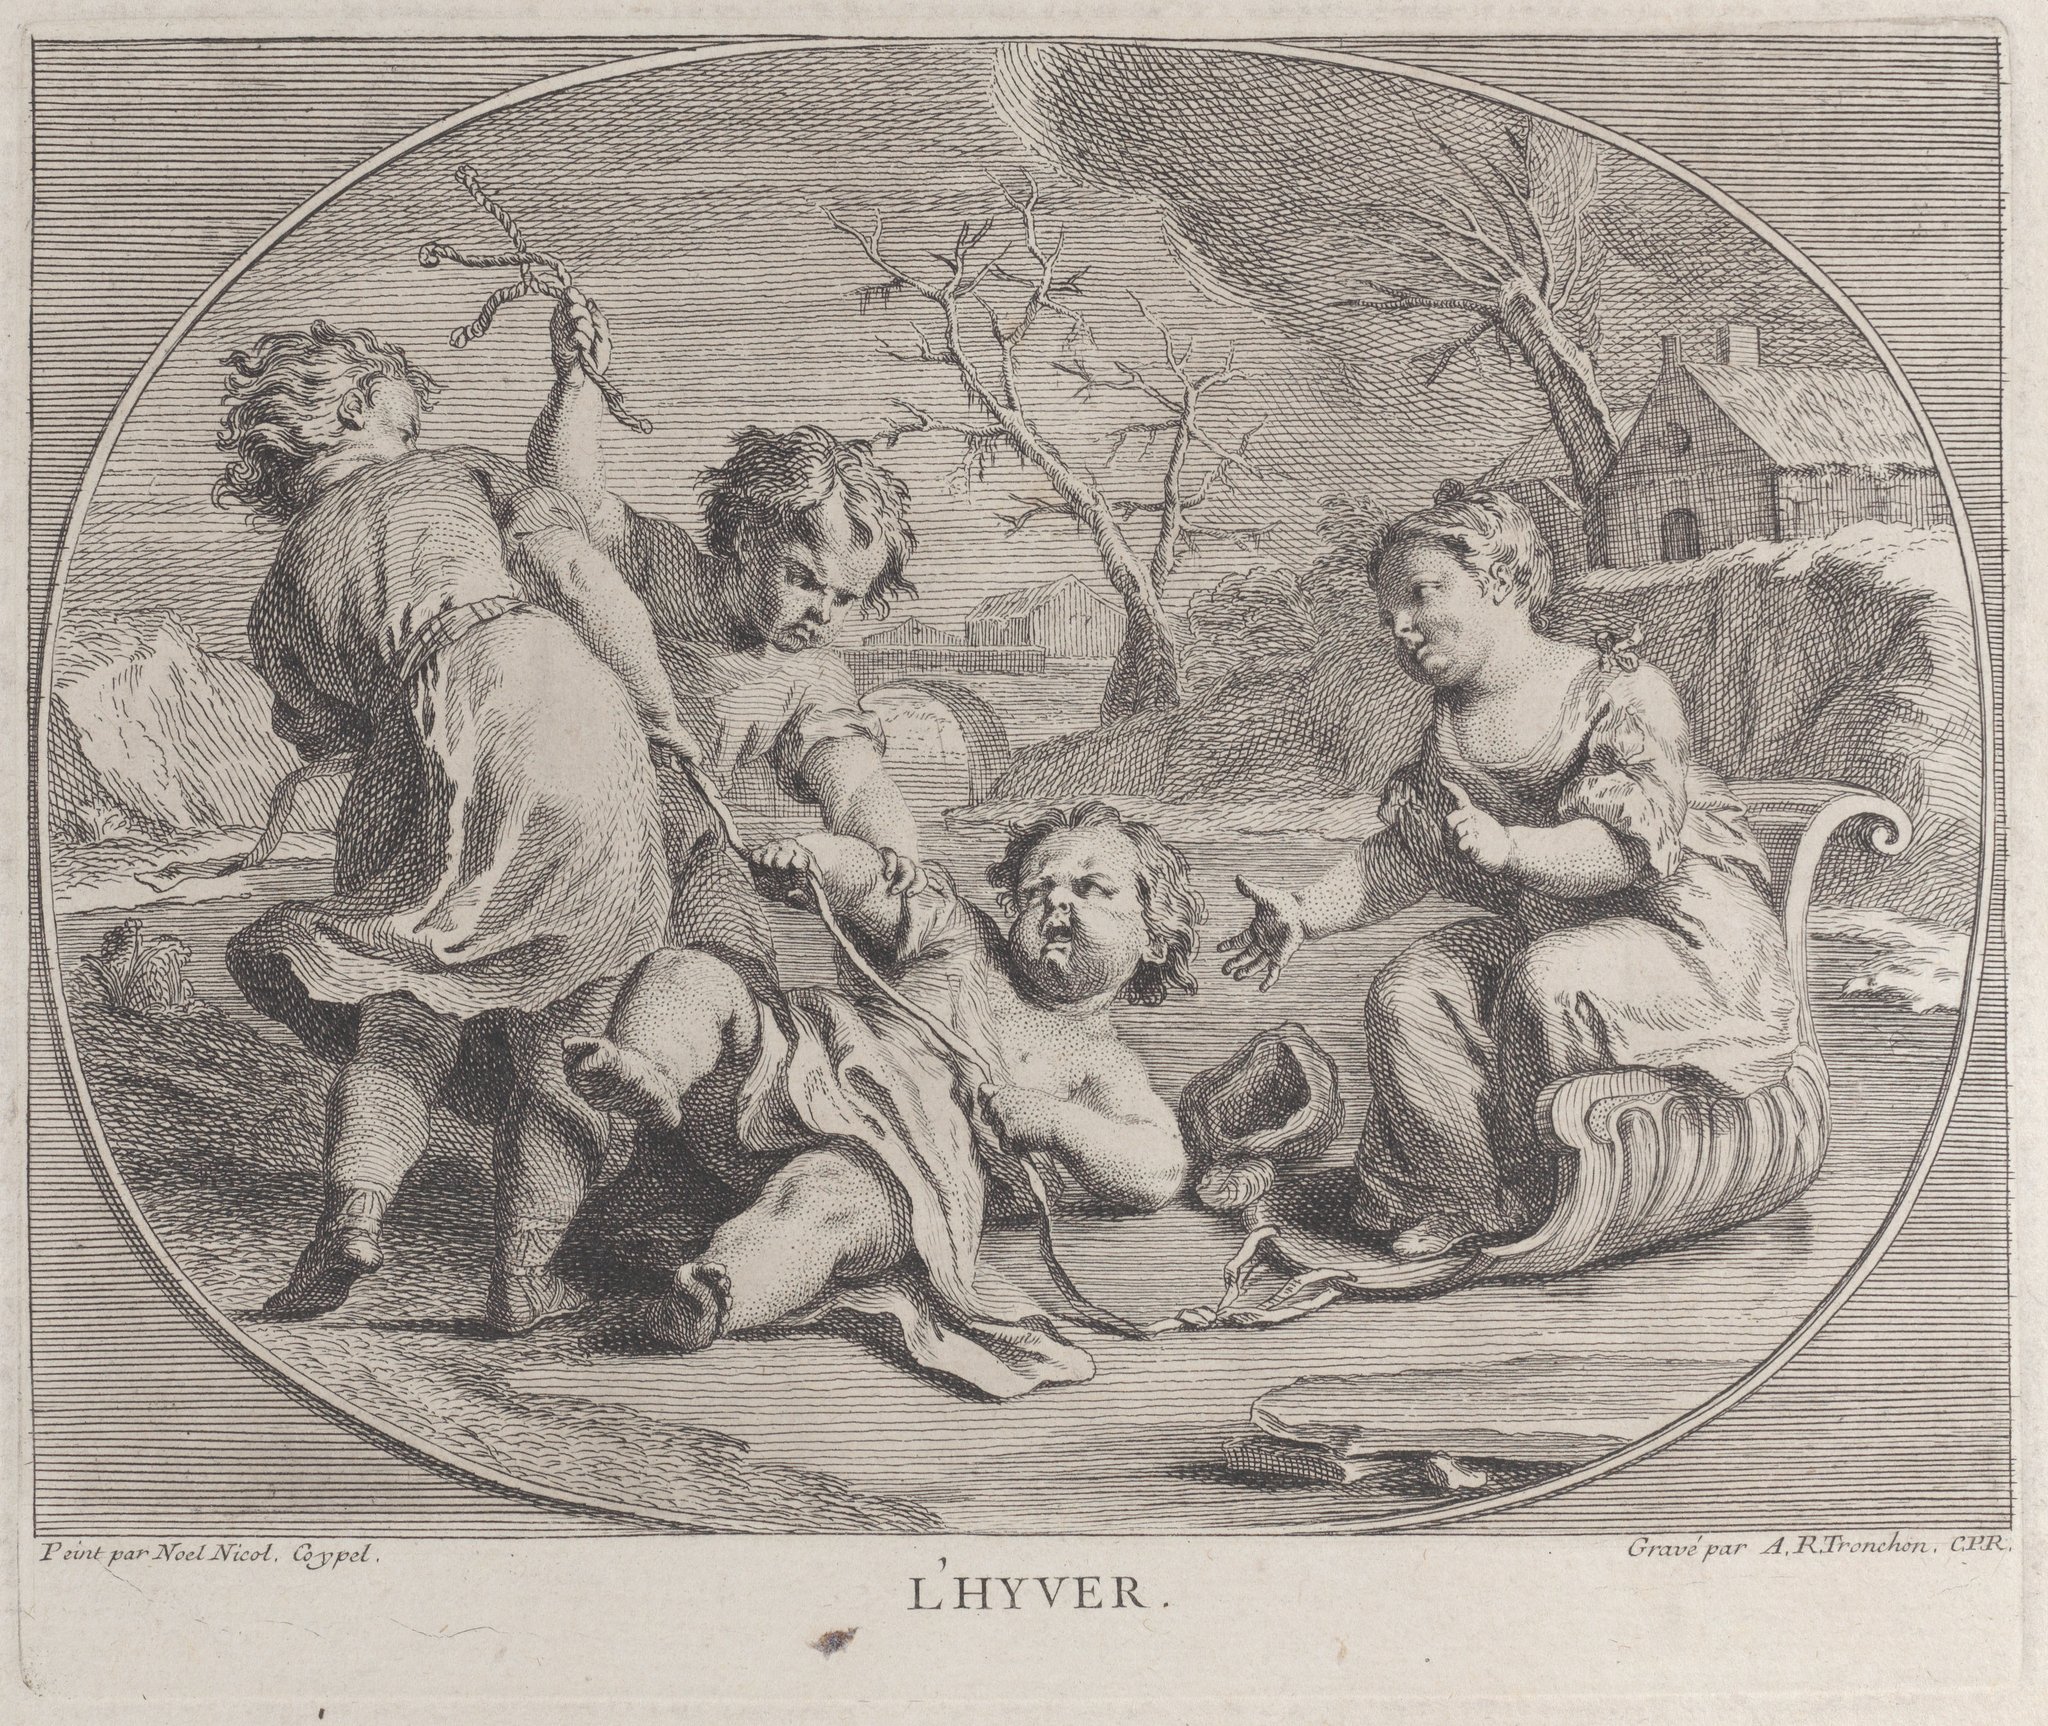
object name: print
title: Winter (L'Hyver)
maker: antoine r. tronchon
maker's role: artist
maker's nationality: french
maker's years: 1700-1800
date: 1740-1760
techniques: engraving, etching